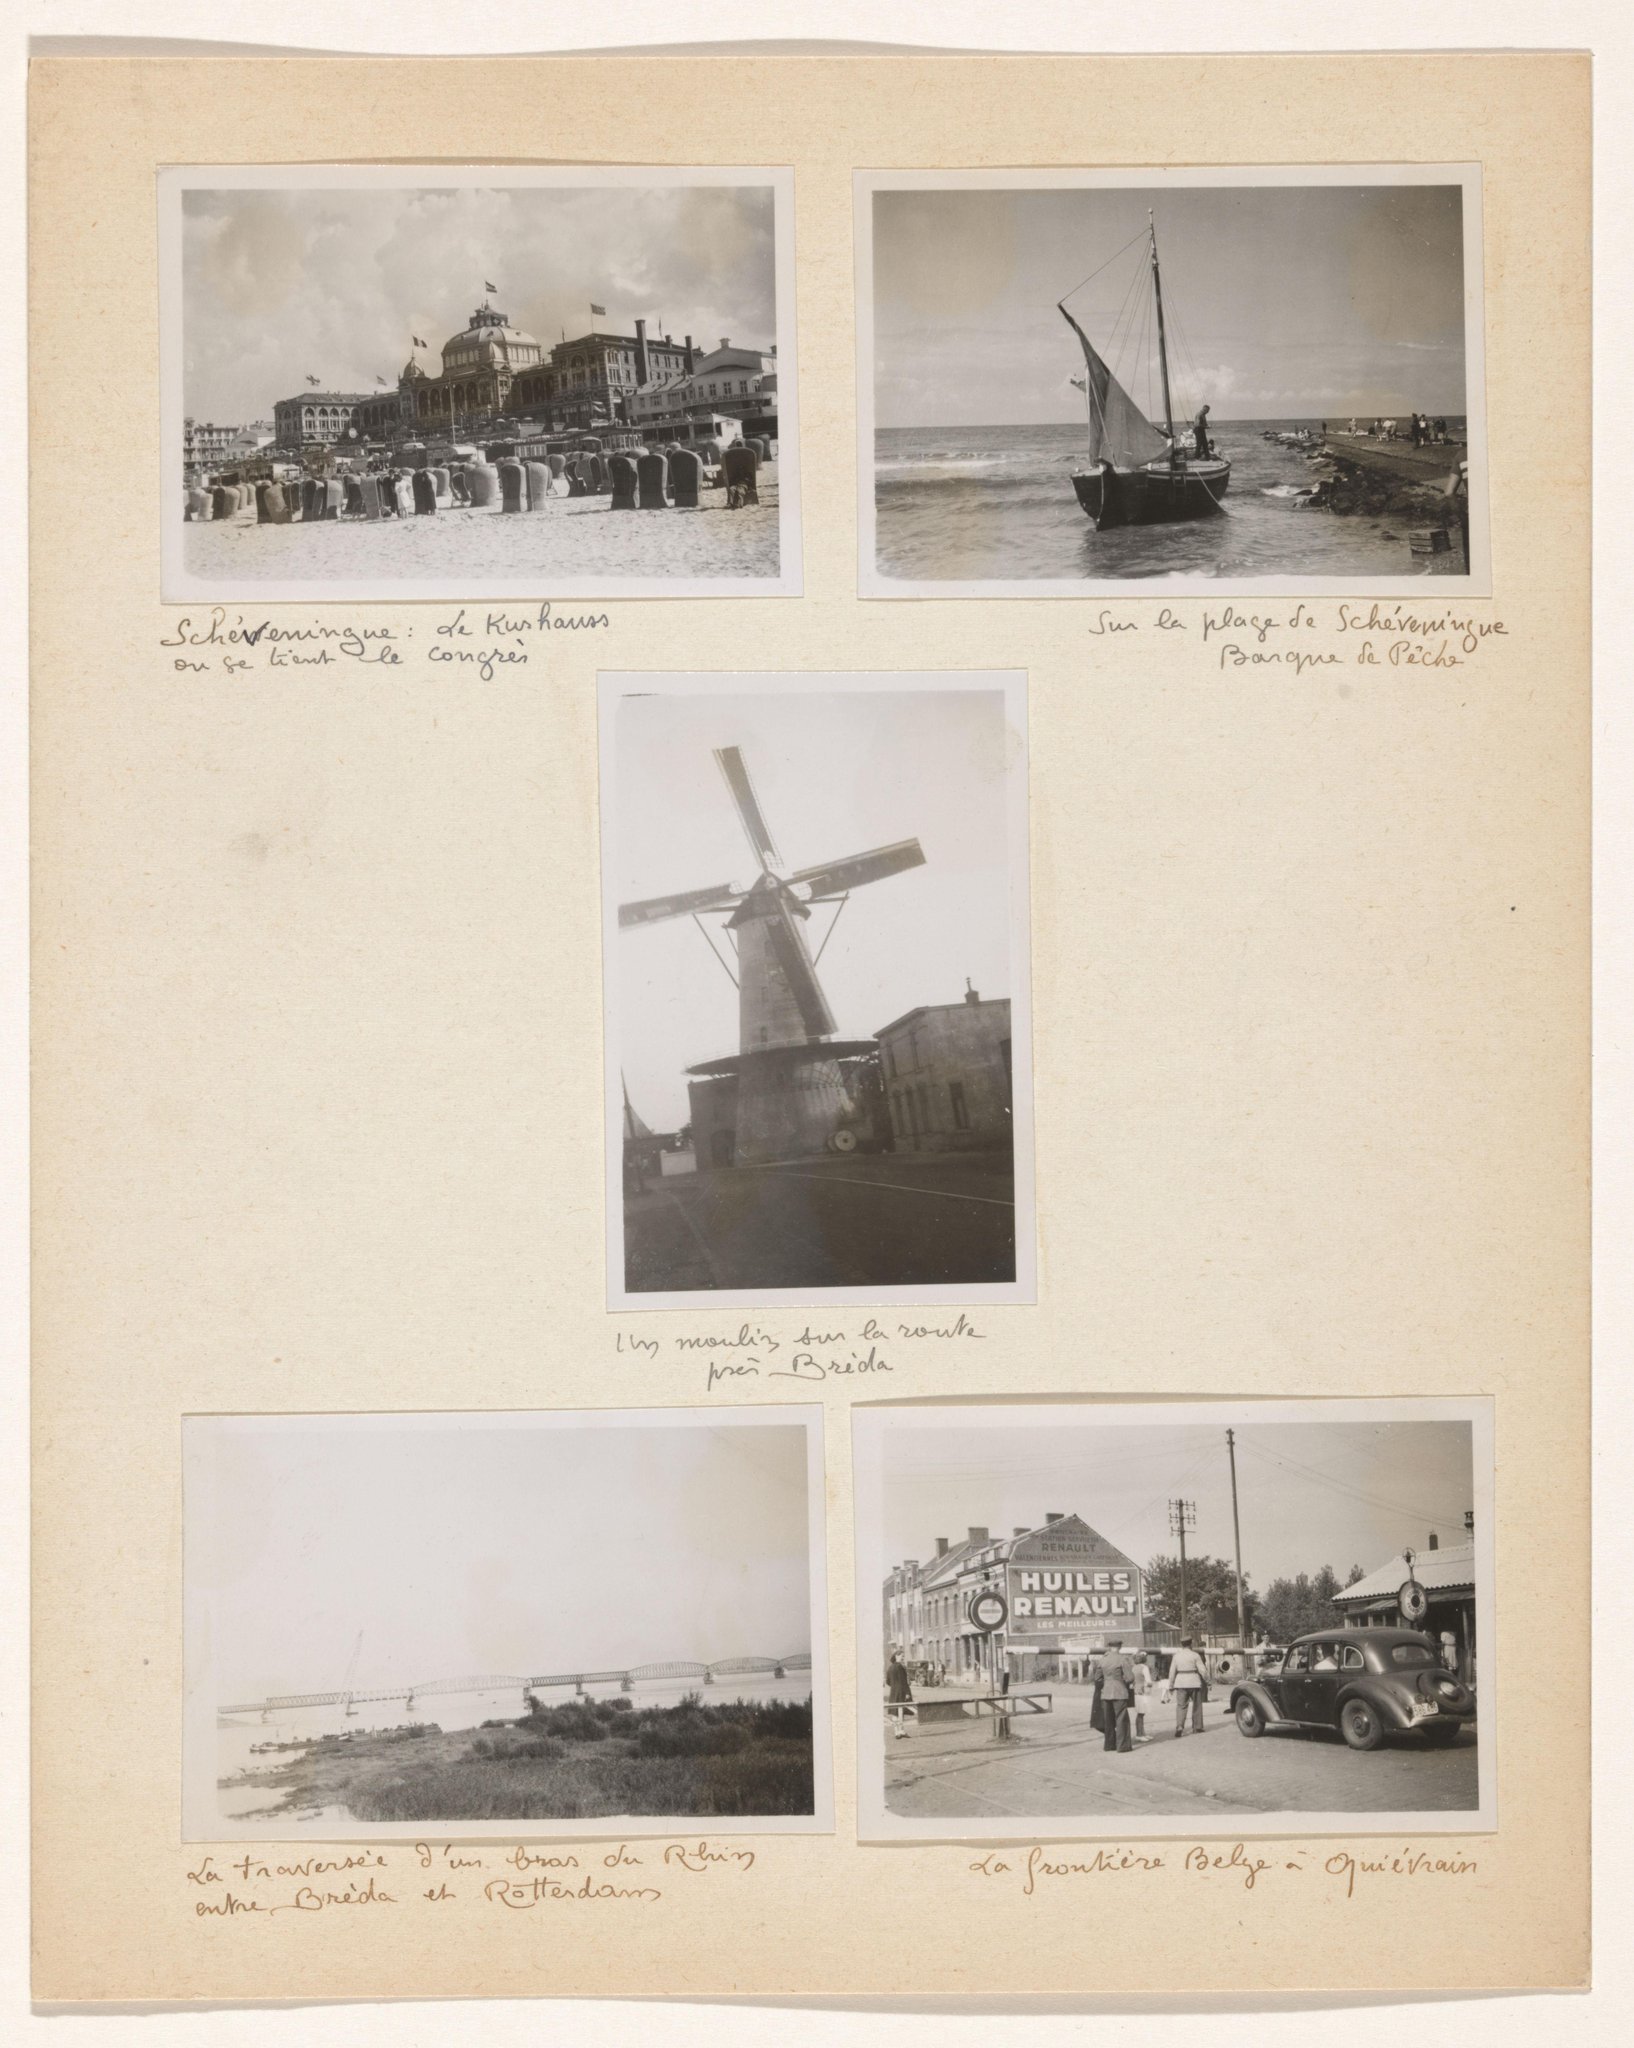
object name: album leaf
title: Albumblad met vijf foto's van Nederland en België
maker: Anonymous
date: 1935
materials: paper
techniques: gelatin silver print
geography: netherlands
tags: beach (as place of recreation), city-view in general; 'veduta', windmill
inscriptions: inscription: ‘Schéveningen: Le Kurhaus (...) à Quiévrain’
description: Albumblad met vijf foto's van onder meer Scheveningen en Moerdijk